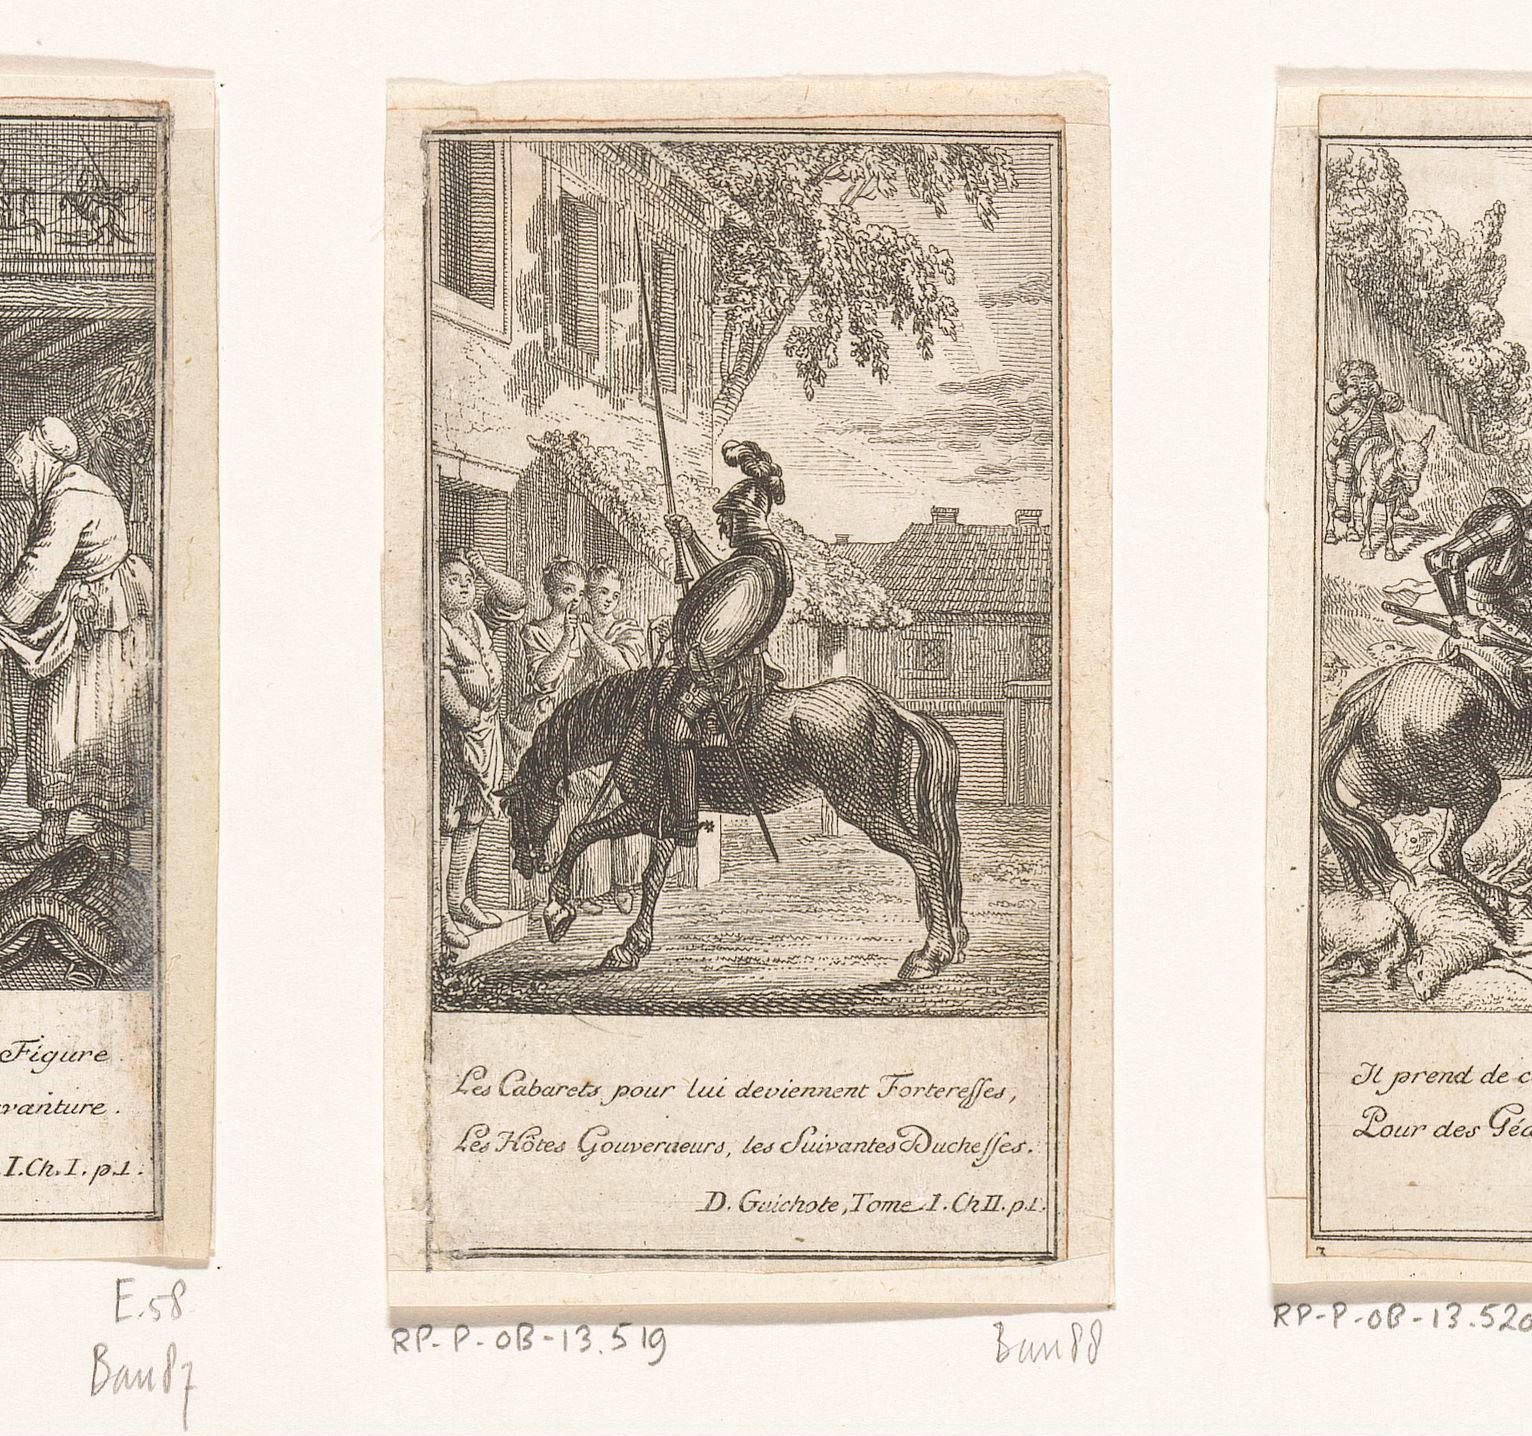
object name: print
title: Don Quichot voor de herberg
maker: daniel nikolaus chodowiecki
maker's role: draughtsman, print maker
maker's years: 1726-1801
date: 1770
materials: paper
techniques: etching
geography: berlin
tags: pavement, terrace in front of inn or restaurant, don quixote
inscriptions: collector's mark: Lugt 2228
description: Tweede prent van een serie van twaalf scènes die het verhaal van Don Quichot door Miguel de Cervantes Saavedra illustreren. De scènes werden op een plaat geëtst. Deze serie werd ook gebruikt in: 'Almanac Genealogique pour l'an 1771'.